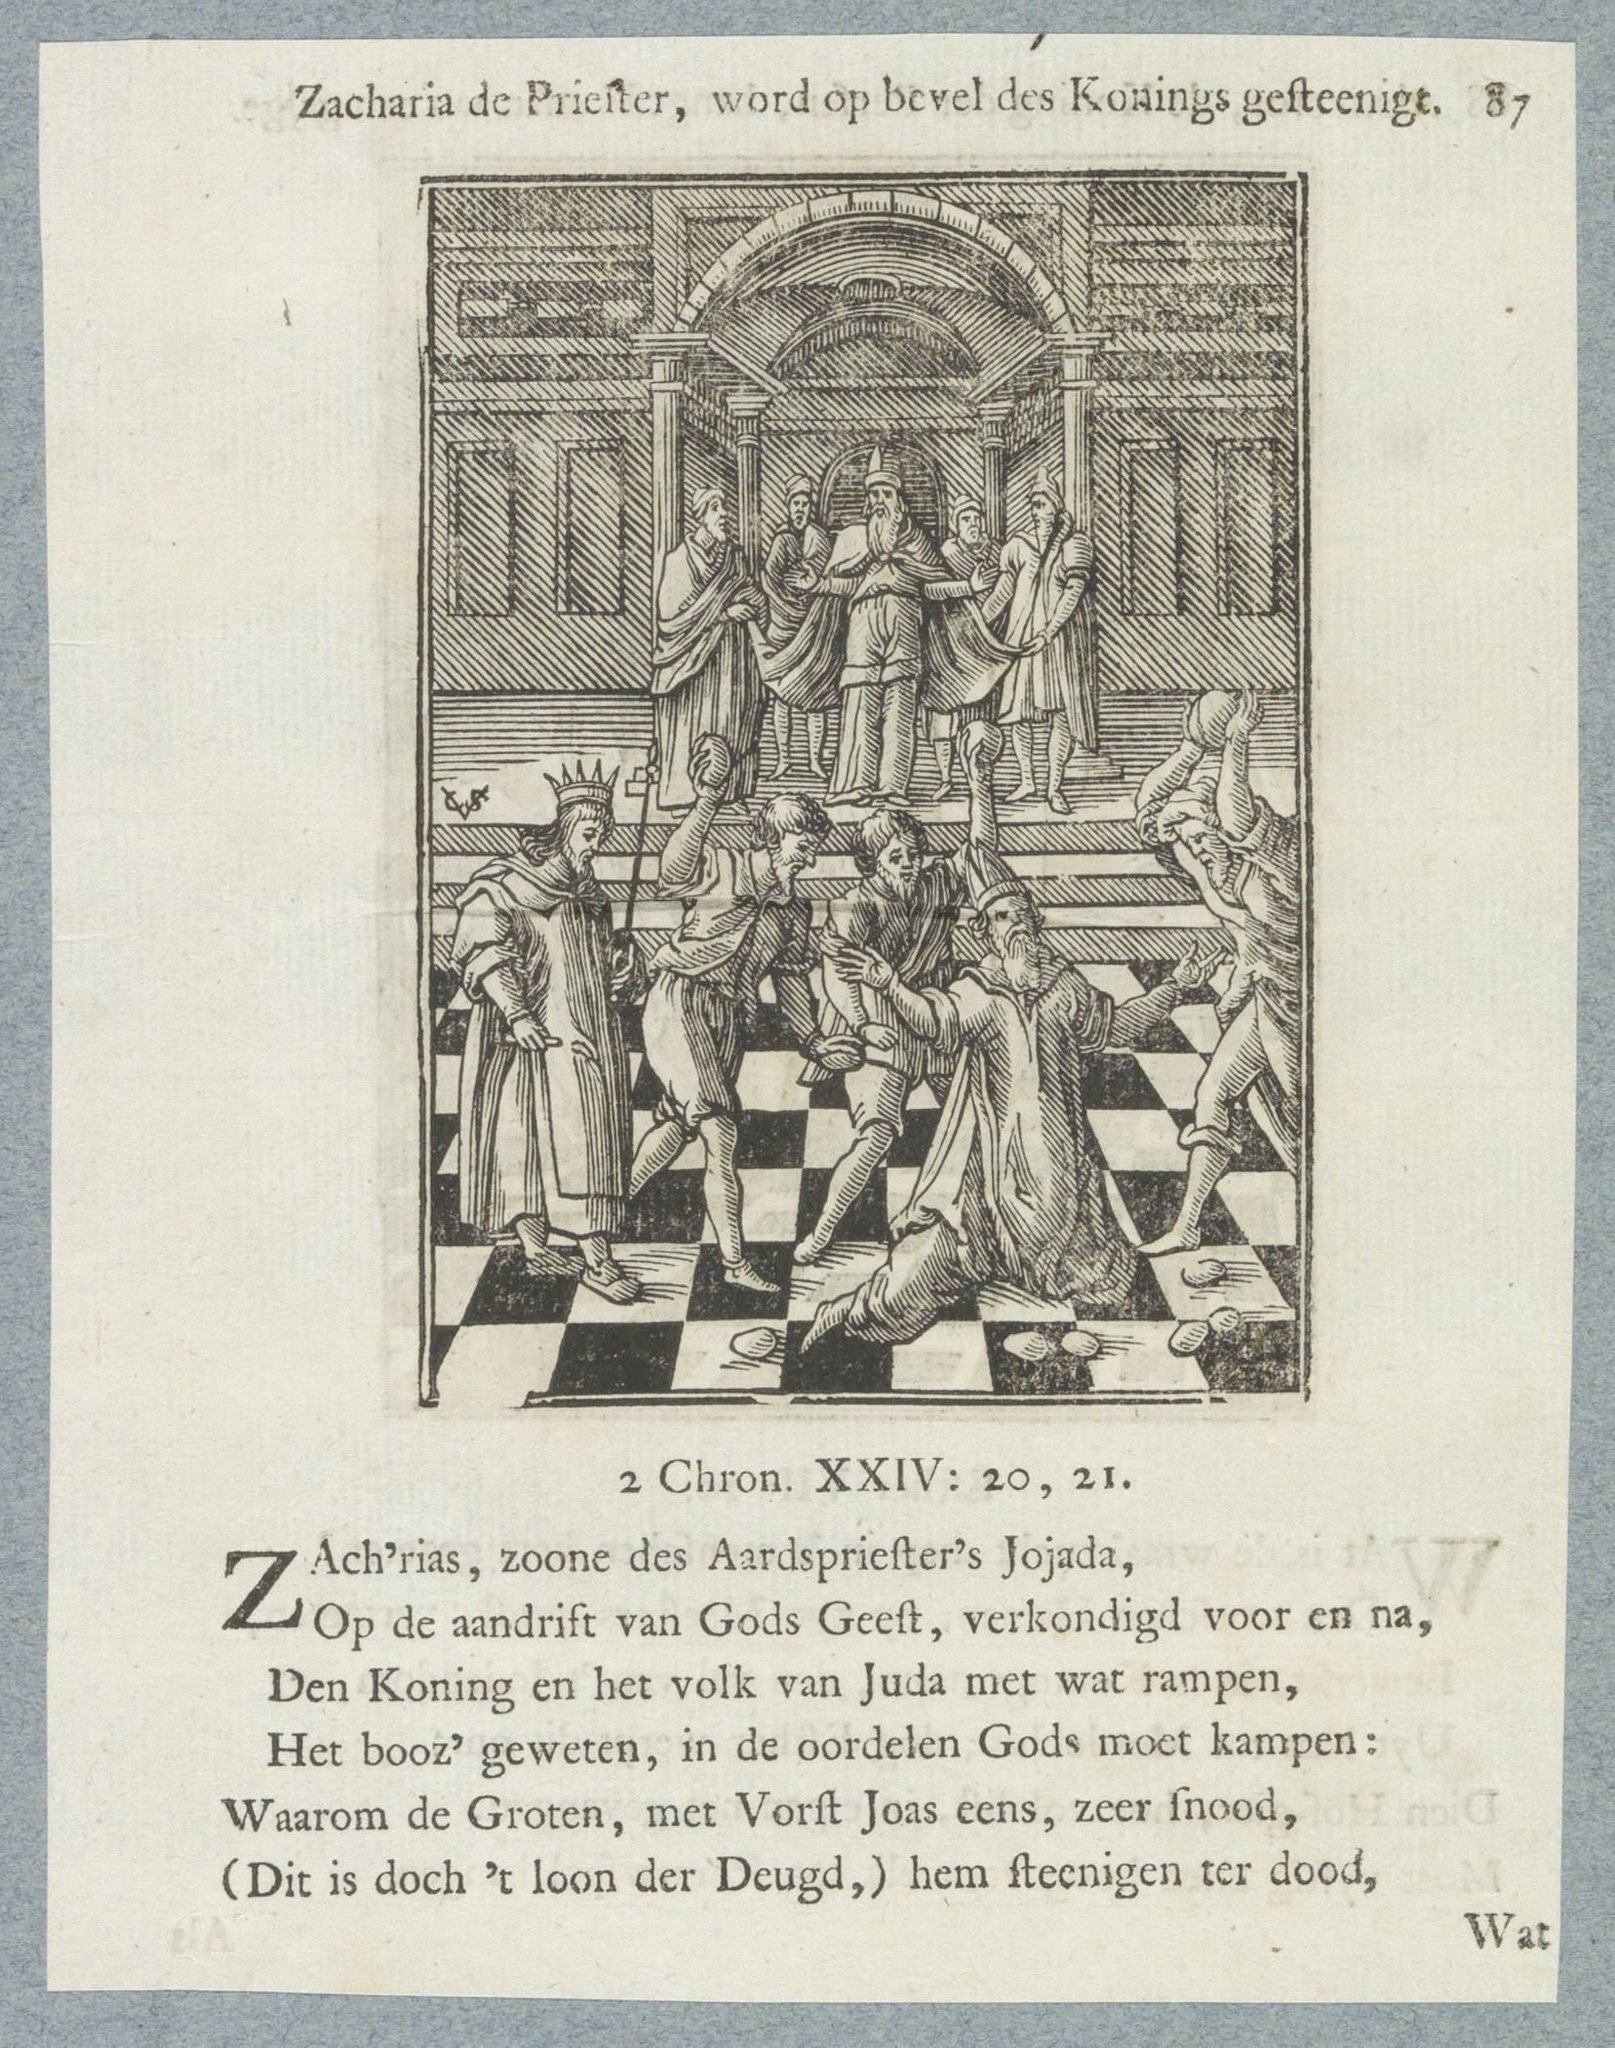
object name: album leaf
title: Zacharia de priester, word op bevel des konings gesteenigt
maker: jan klooster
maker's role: bookseller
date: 1645-1646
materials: paper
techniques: letterpress printing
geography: amsterdam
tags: at the king's order the people stone zechariah in the temple courtyard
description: De prent is afkomstig uit: Bybels Lusthof. Amsterdam, J. Klooster, 1740. De prent werd gemaakt voor de uitgaven van P.J. Paets uit Amsterdam. Ze komt in ieder geval voor in: Bibels Tresoor ofte der zielen lusthof. Amsterdam, P.J. Paets, 1646. Mogelijk staat ze ook in: Historien ende Prophetien. [Amsterdam], P.J. Paets, 1645.